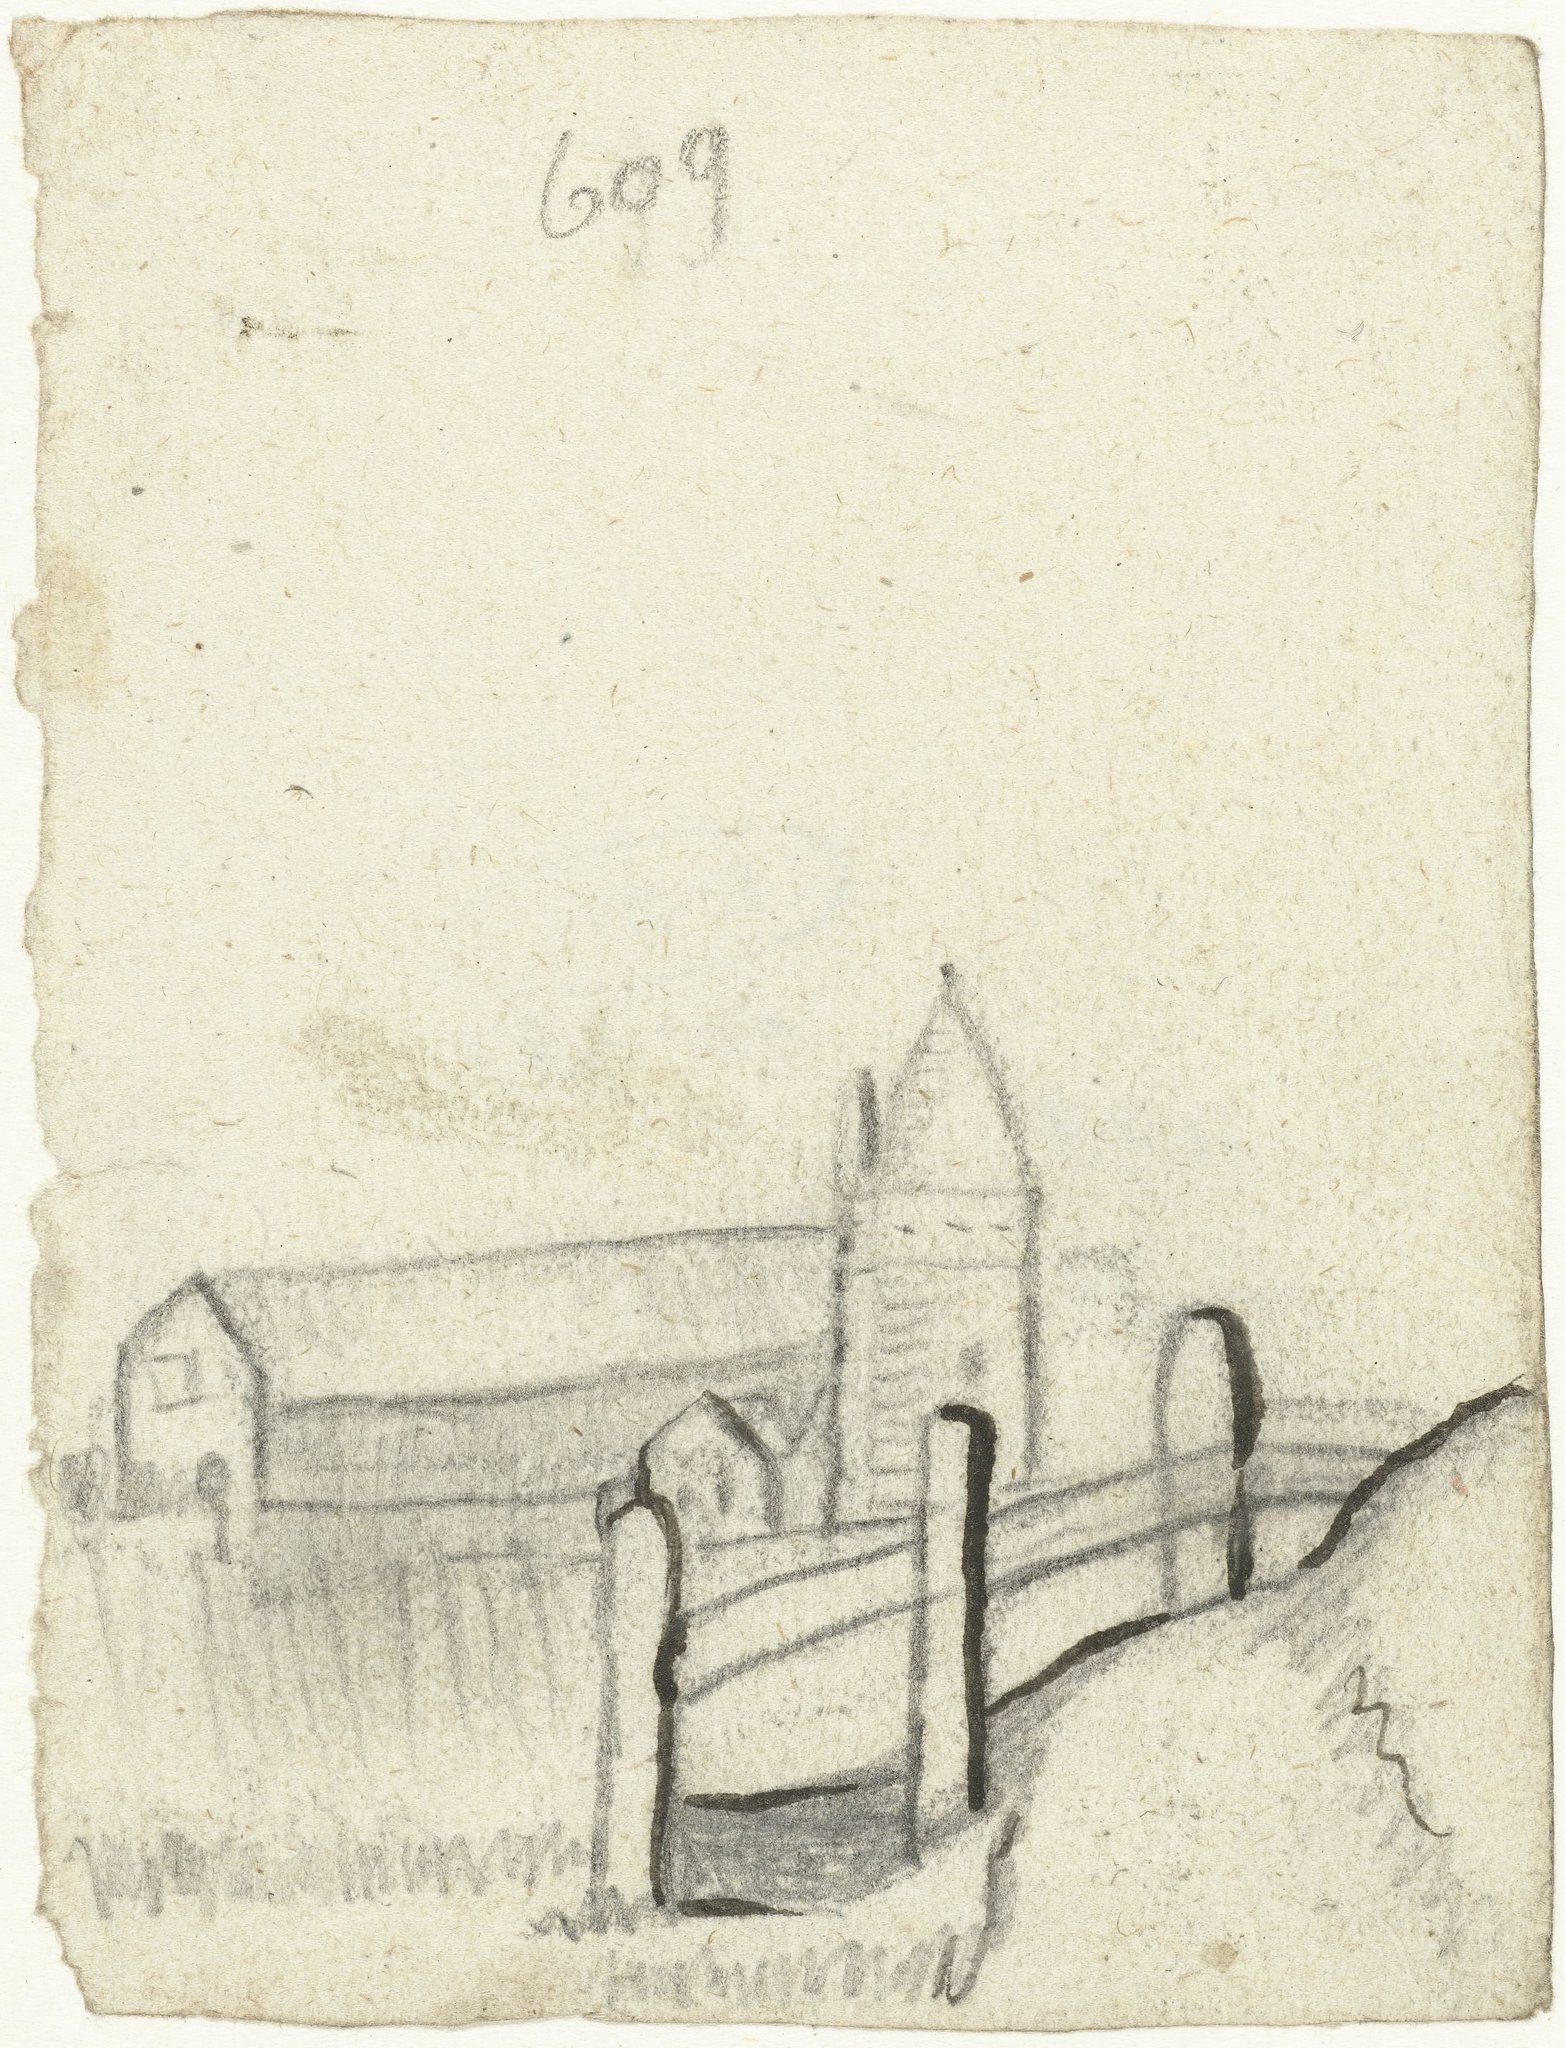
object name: drawing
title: Gezicht op een kerk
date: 1627-1690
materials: ink, paper, pencil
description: Waarschijnlijk een vroege tekening van een van de Ter Borch kinderen.